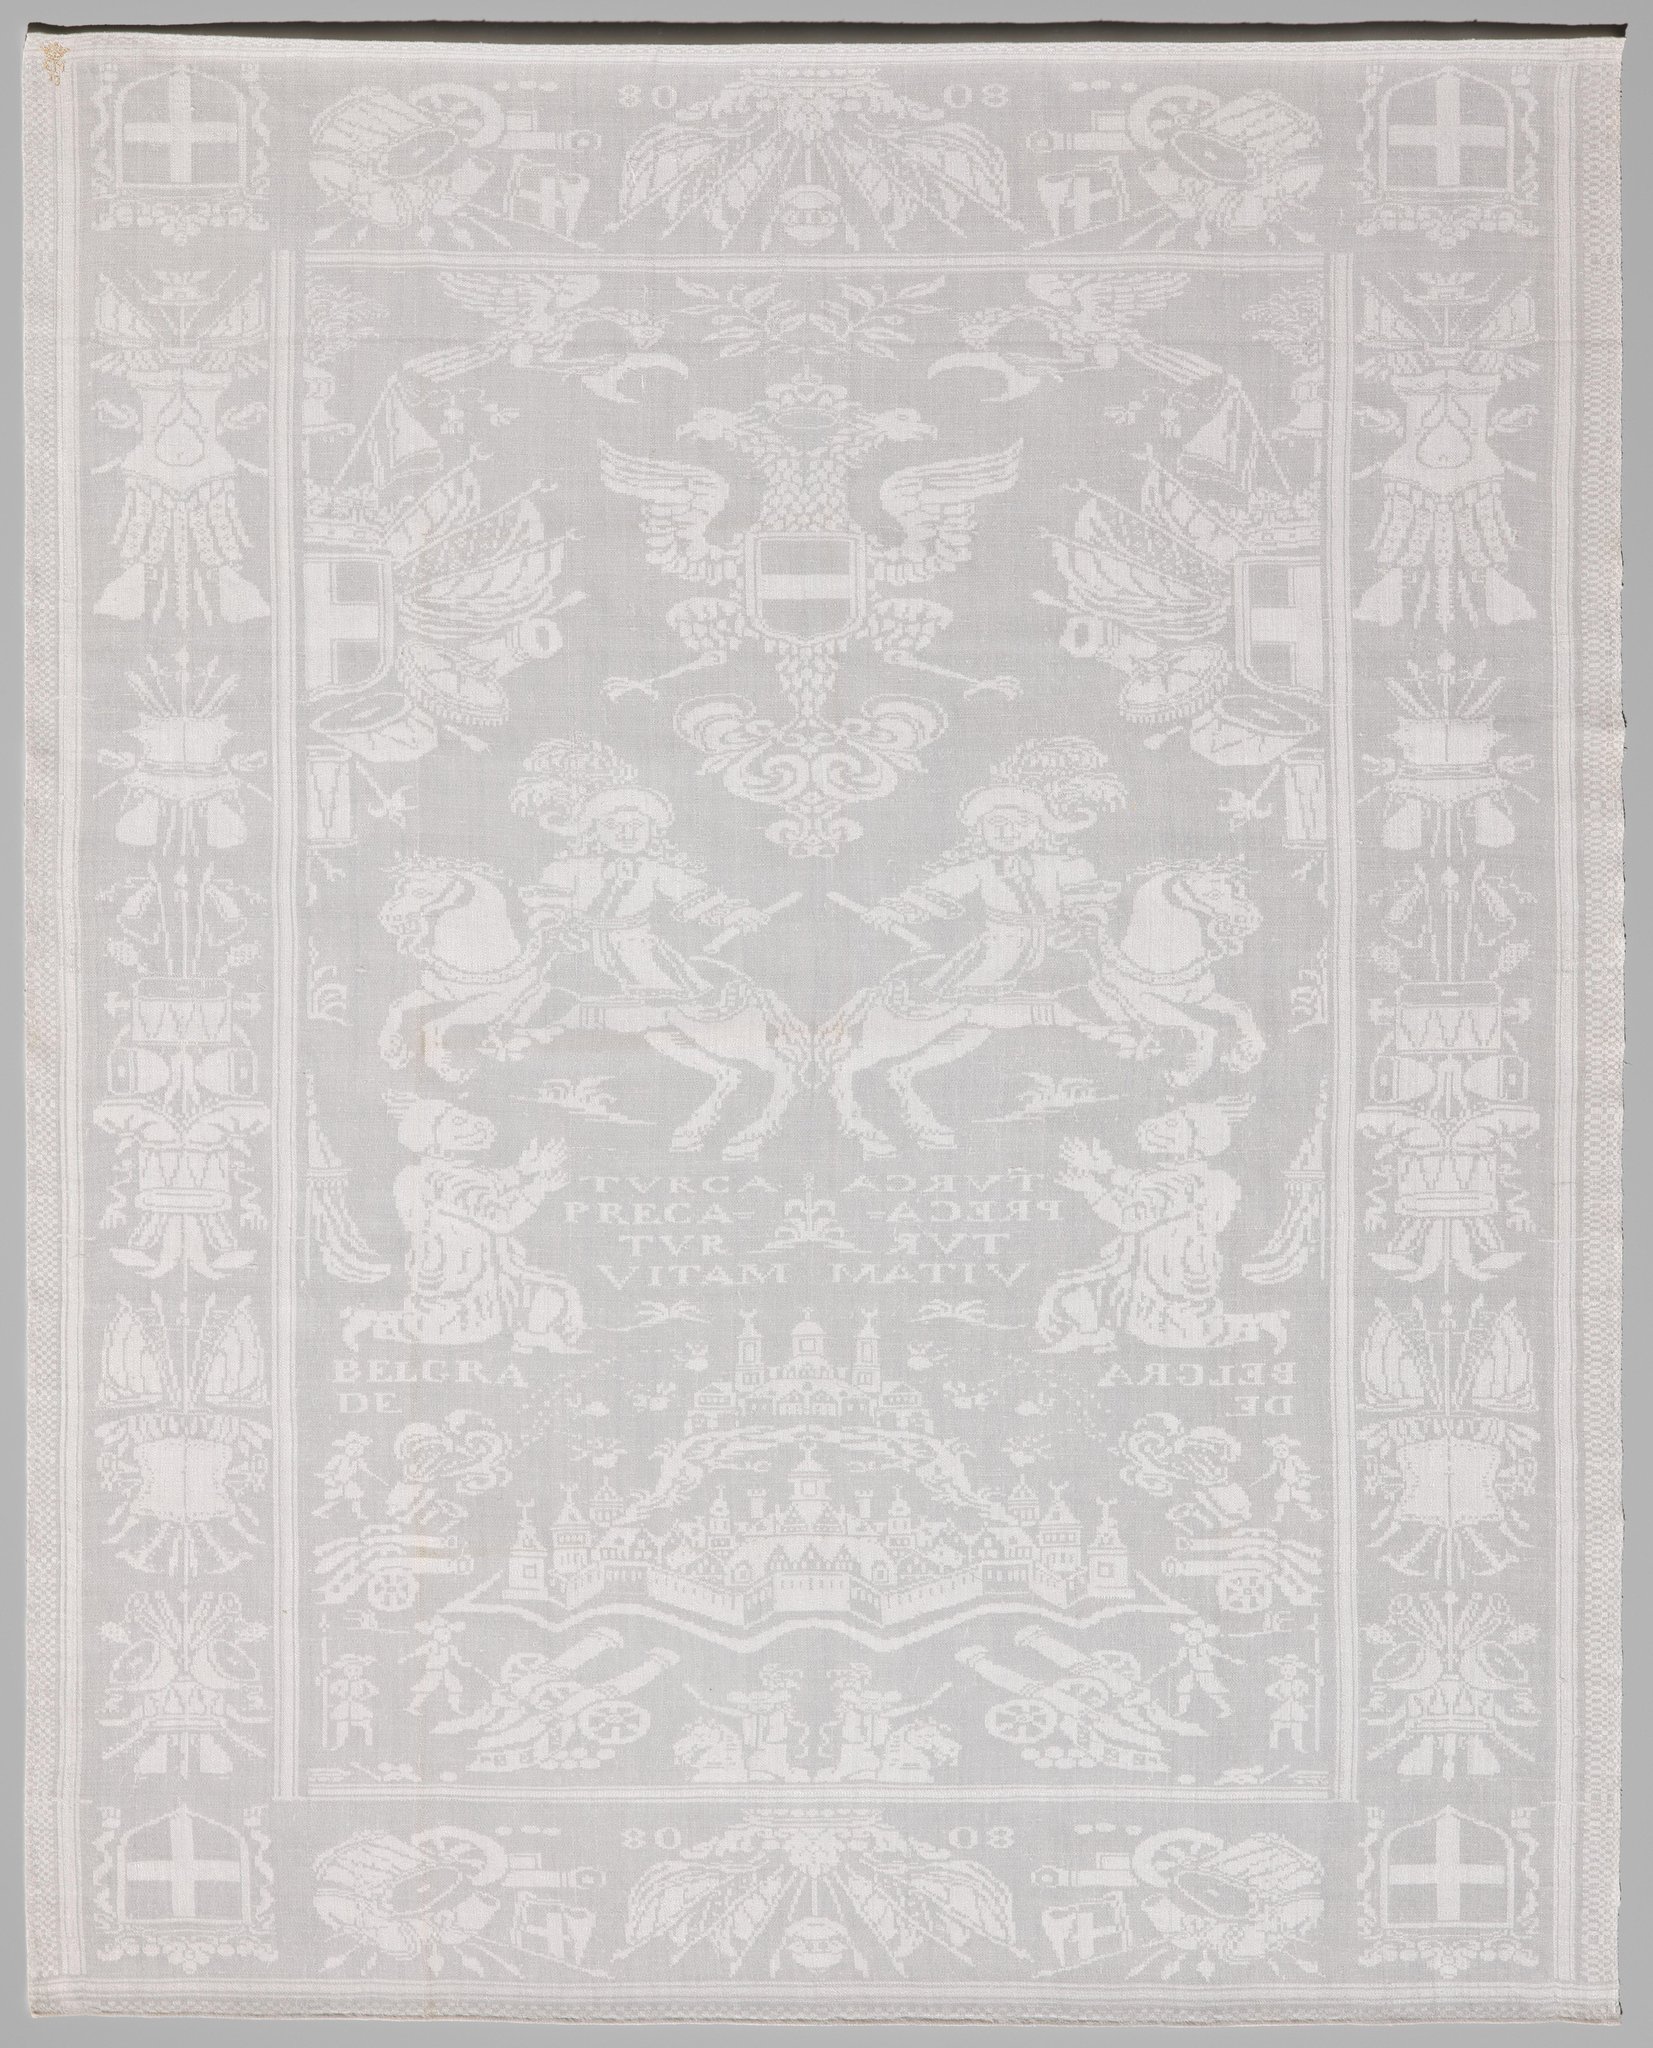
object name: napkin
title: Servet van linnendamast met een historisch tafereel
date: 1717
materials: linen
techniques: damask, weave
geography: flanders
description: Wit linnendamasten servet met de verovering van Belgrado op de Turken door Eugenius van Savoye. Gemerkt E M 13 onder een kroon. Het veld heeft een gespiegeld patroon met van onder naar boven: mannen bij kanonnen, een stad met opschrift BELGRADE, een knielende man met opschrift: TVRCA PRECA TVR VITAM, een ruiter en twee halve wapens. De randen hebben wapen trofeeën en in de hoeken een wapen.